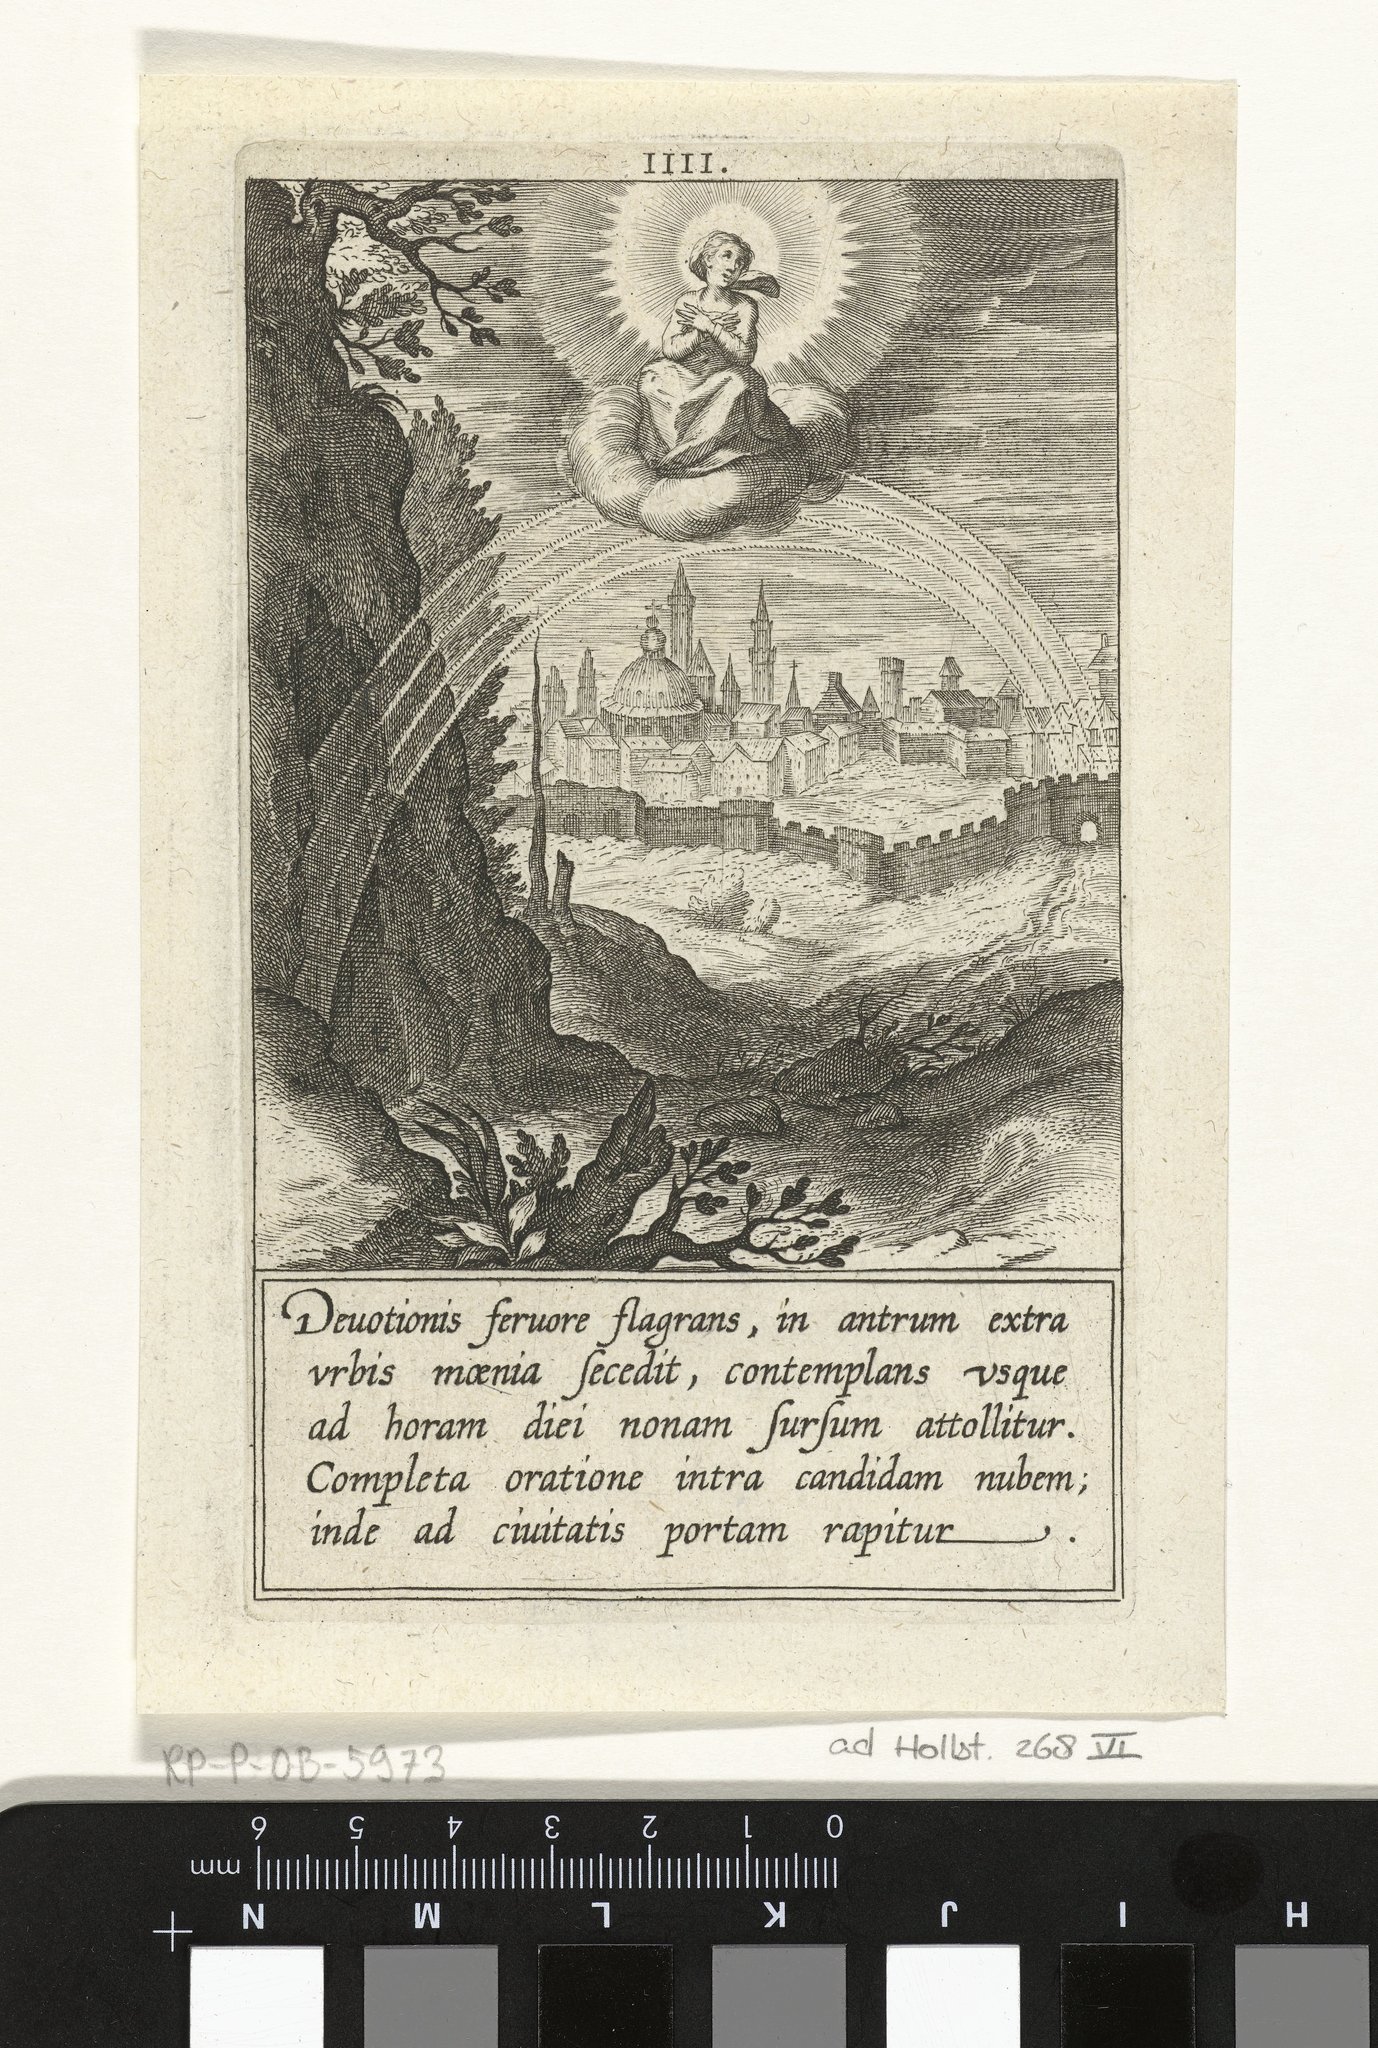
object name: print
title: Het leven van de H. Catharina van Siena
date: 1603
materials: paper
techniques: engraving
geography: southern netherlands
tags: the virgin and dominican tertiary, catherine of siena; possible attributes: book, cross, crown of thorns, crucifix, demon under foot, heart (with cross), lily, plague-stricken, ring, rosary, stigmata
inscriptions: collector's mark: Lugt 2228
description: Catharina zit op een wolk die boven een regenboog zweeft. De regenboog loopt van een plek buiten de stadsmuren tot aan de stadspoort. Deel van een serie over Catharina van Siena bestaande uit een titelprent, een portret en 32 genummerde scènes uit haar leven.